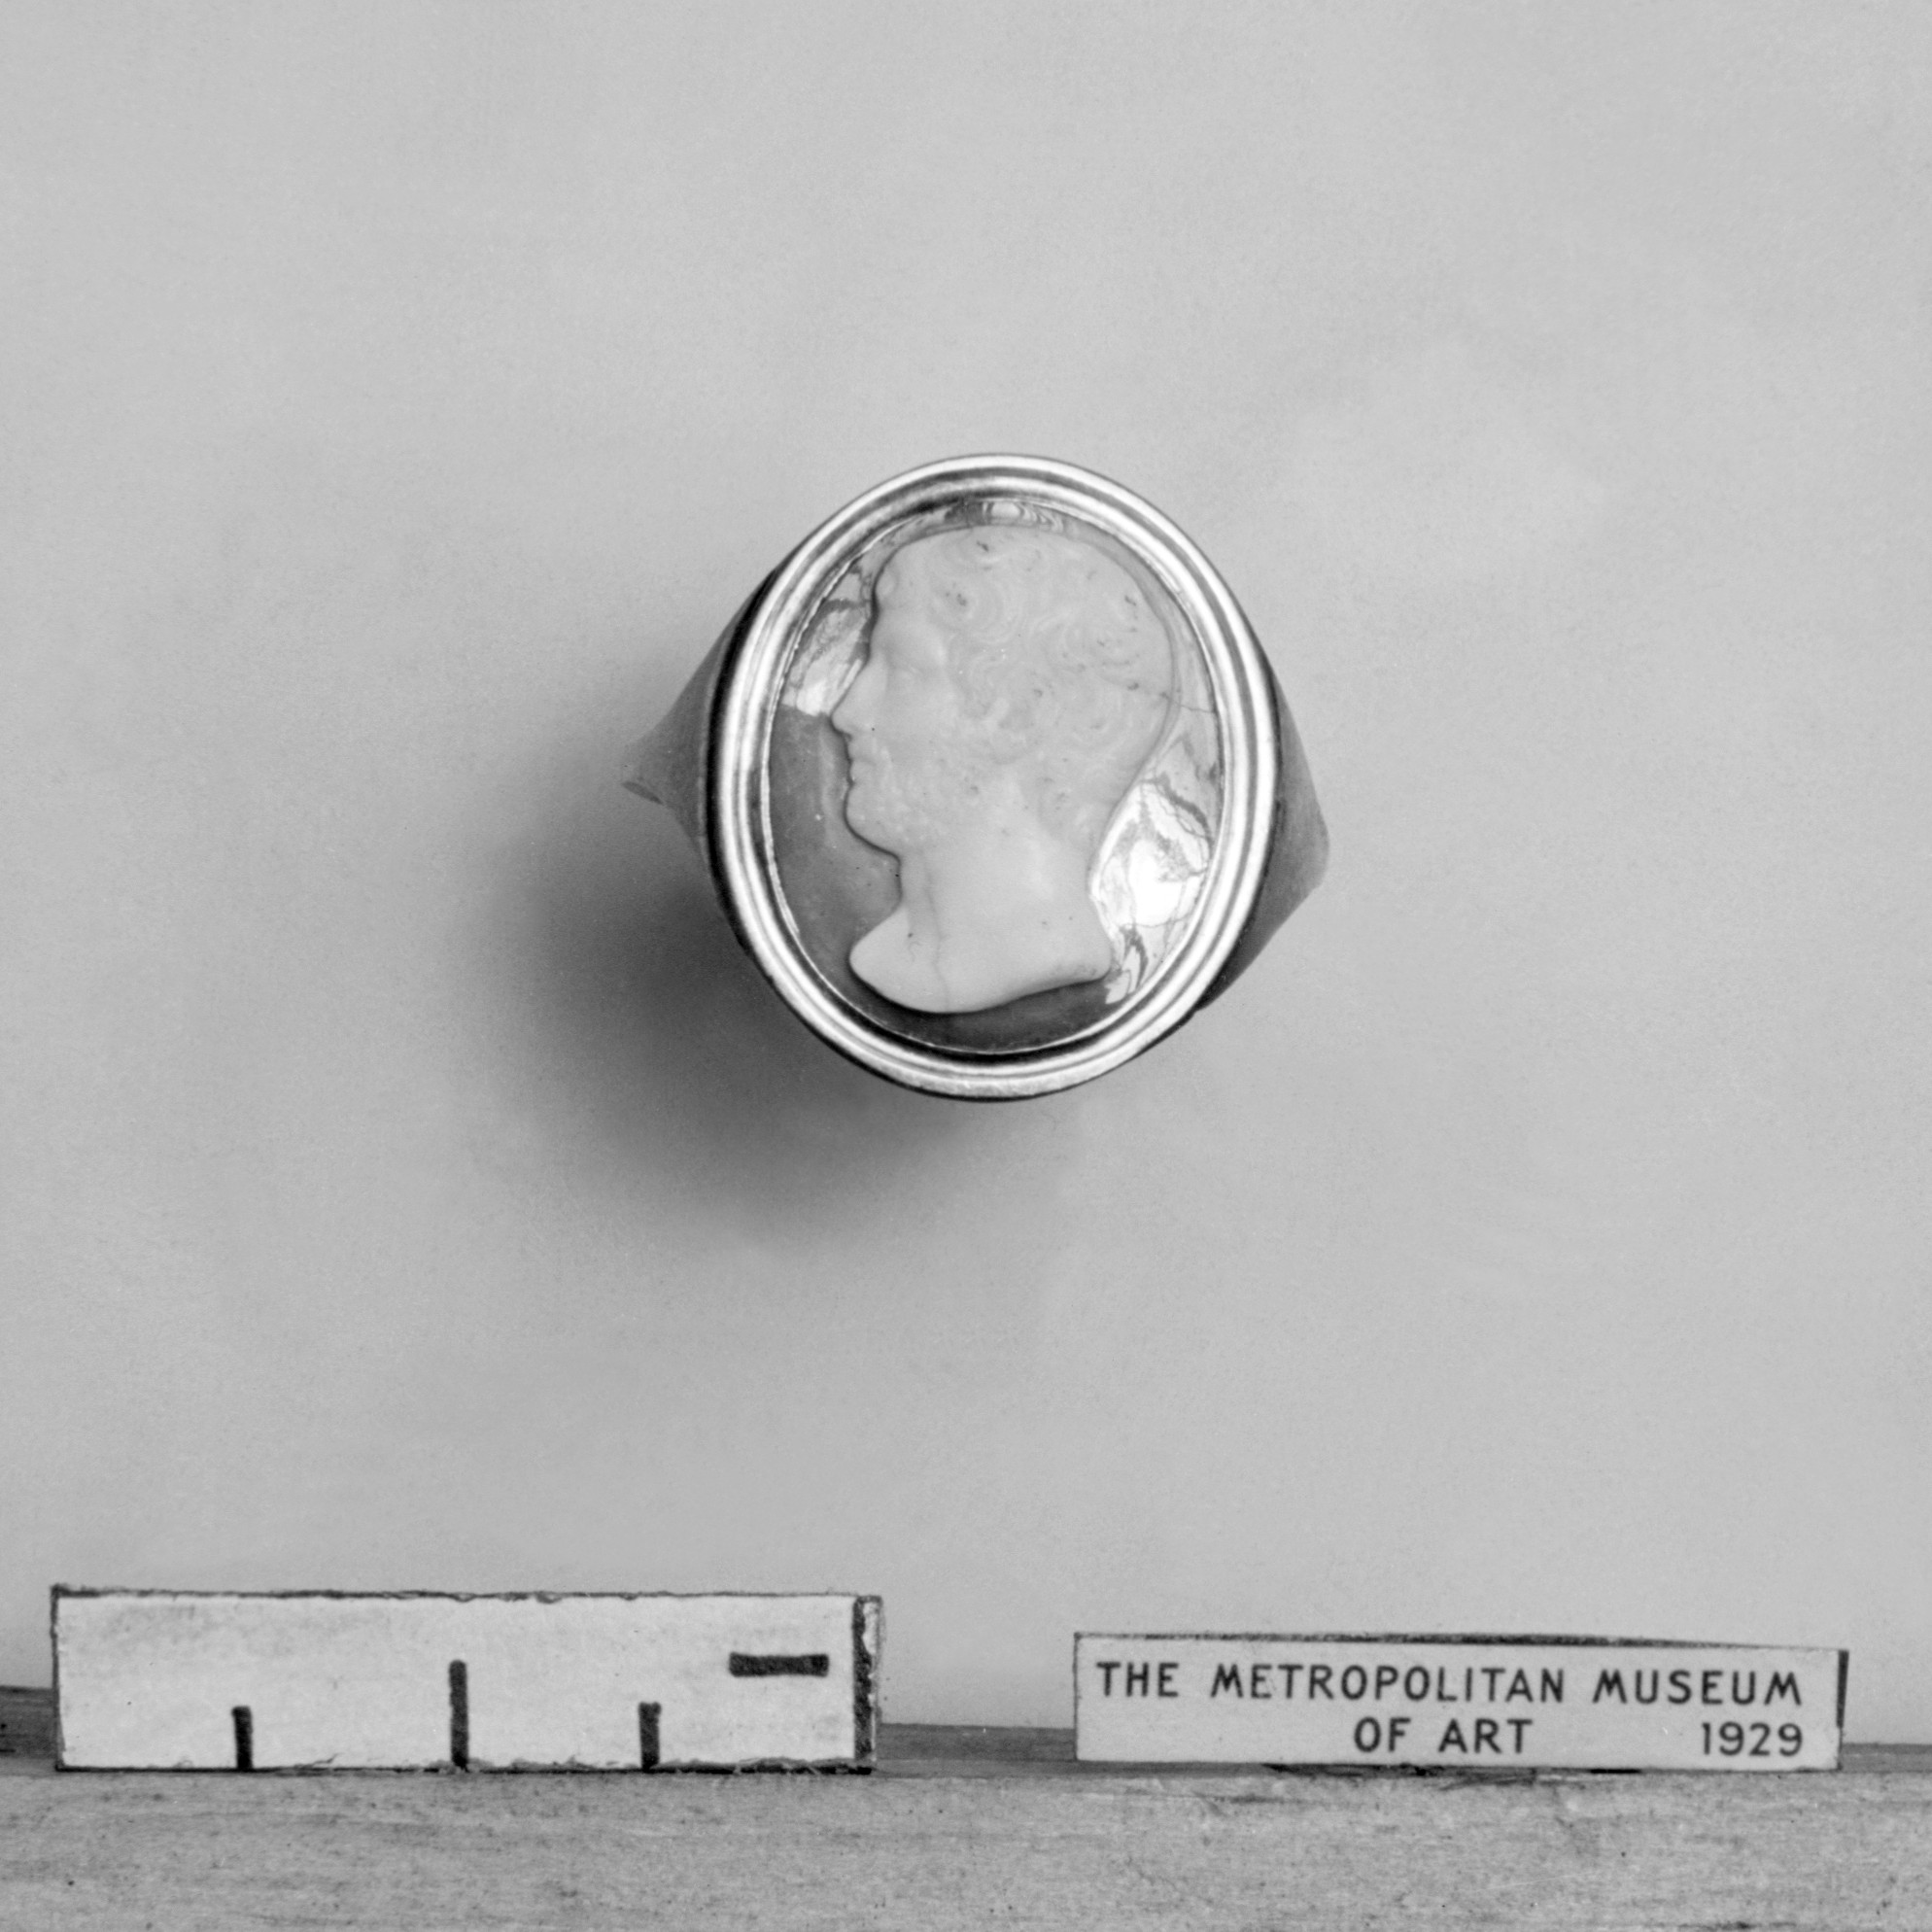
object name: cameo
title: Roman Emperor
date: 1501-1800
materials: gold, gemstone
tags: men,profiles